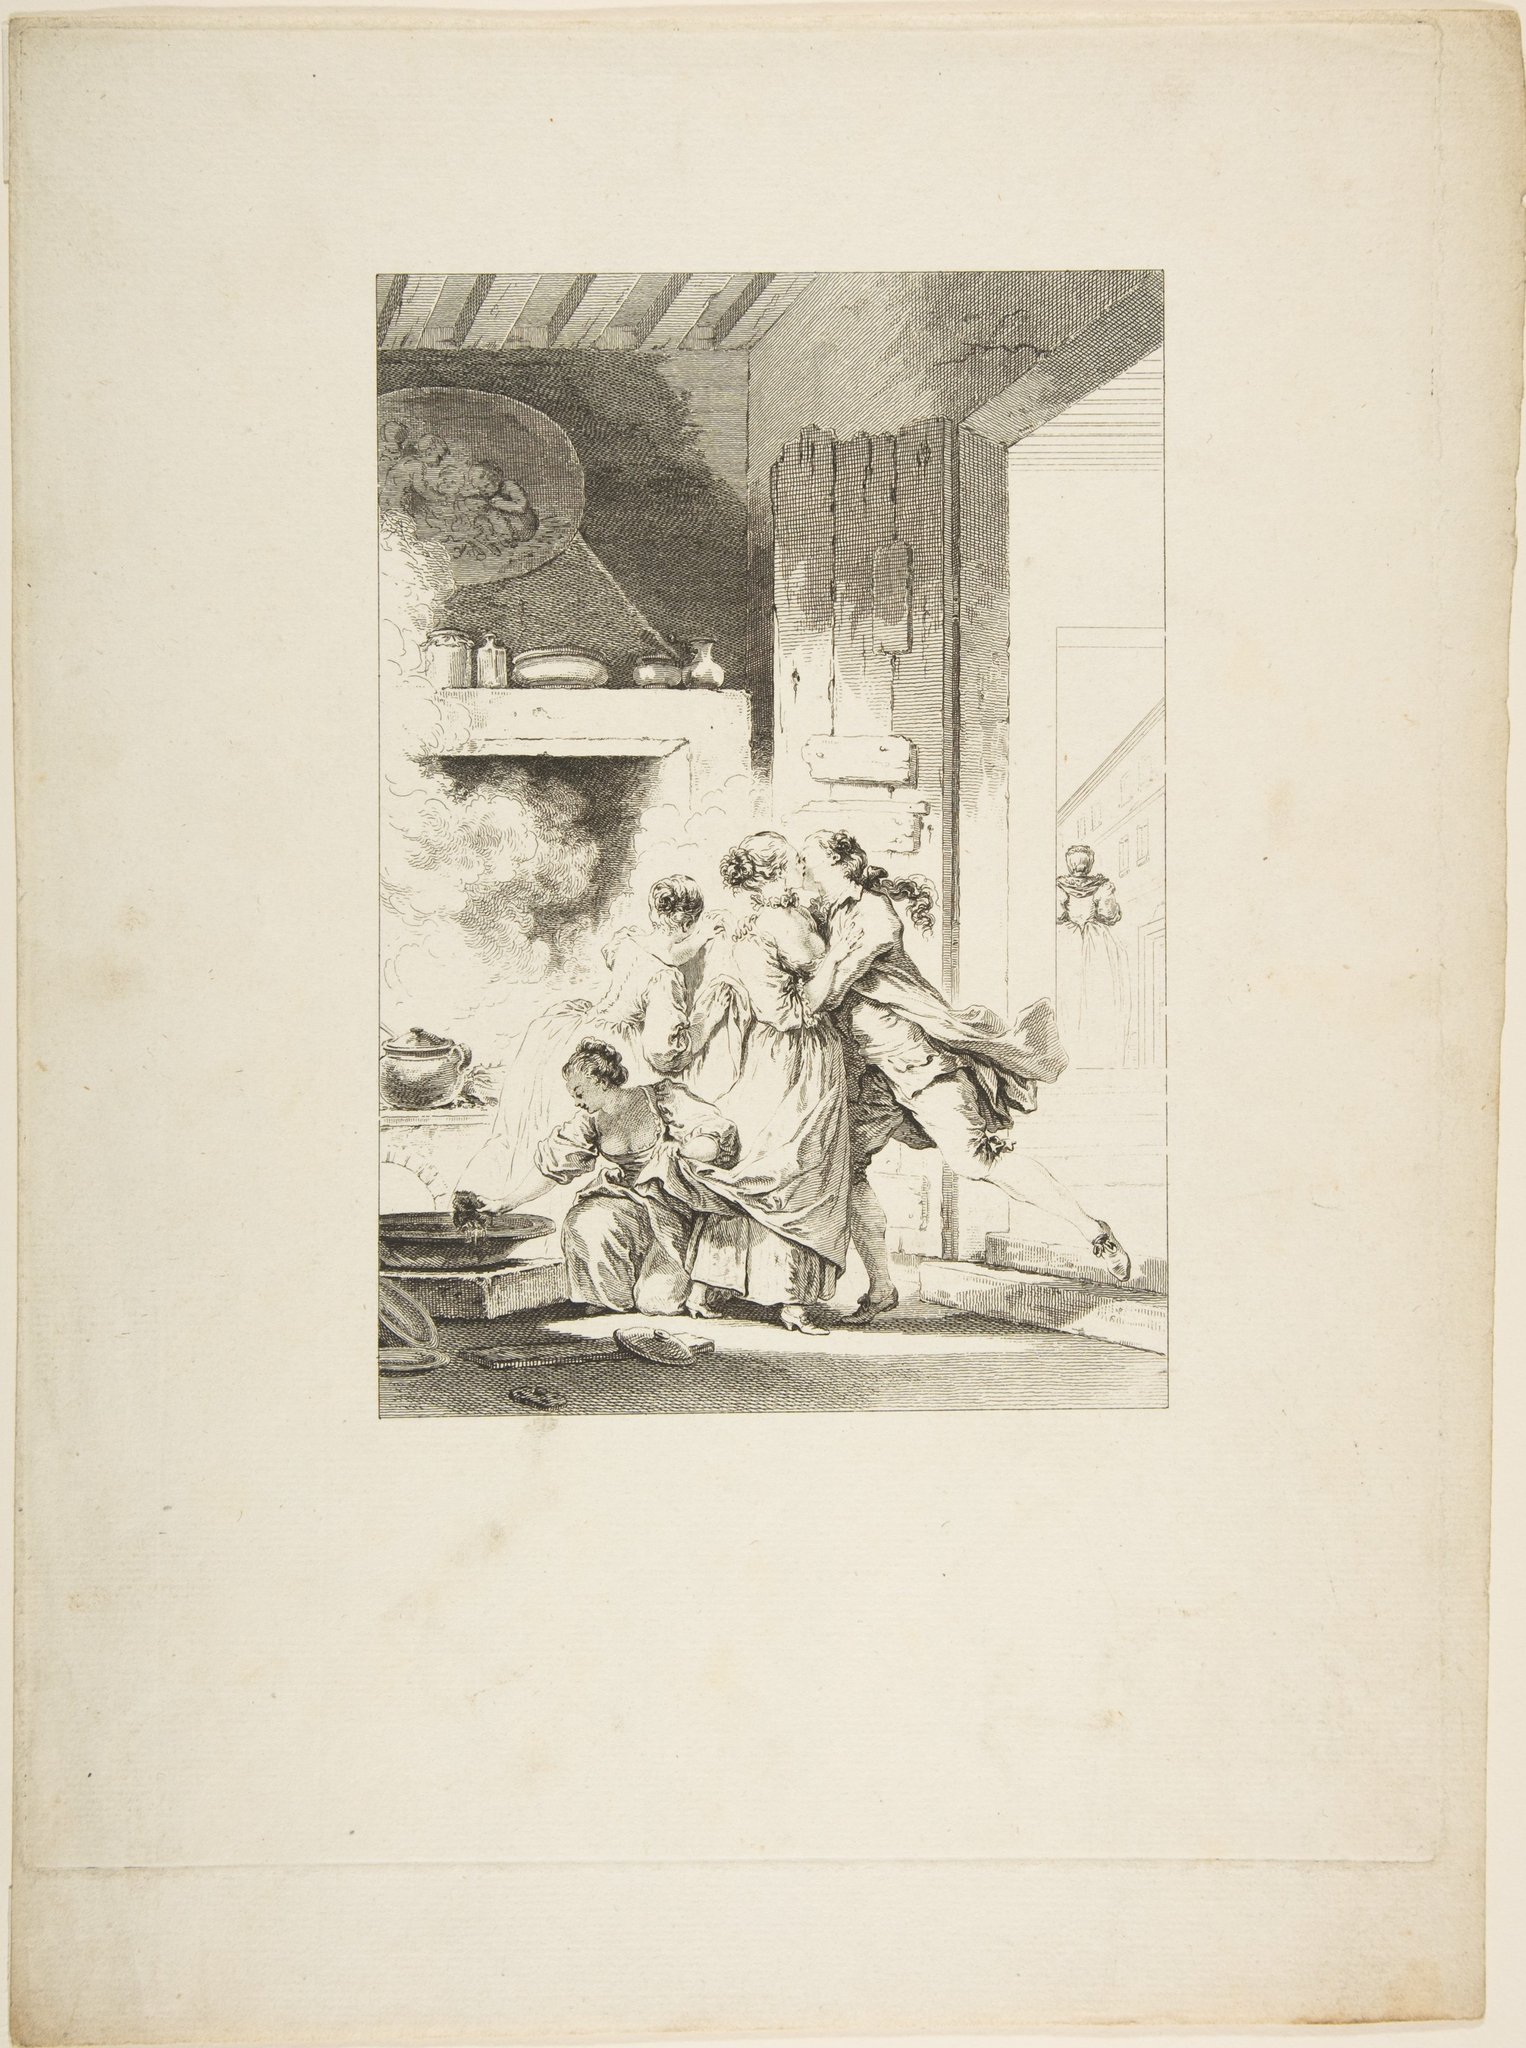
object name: print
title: On ne s'avise jamais du tout, from "Contes et nouvelles en vers par Jean de La Fontaine. A Paris, de l'imprimerie de P. Didot, l'an III de la République, 1795"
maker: jean-baptiste patas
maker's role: artist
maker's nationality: french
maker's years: 1744-1802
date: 1795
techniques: etching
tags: men,women,working